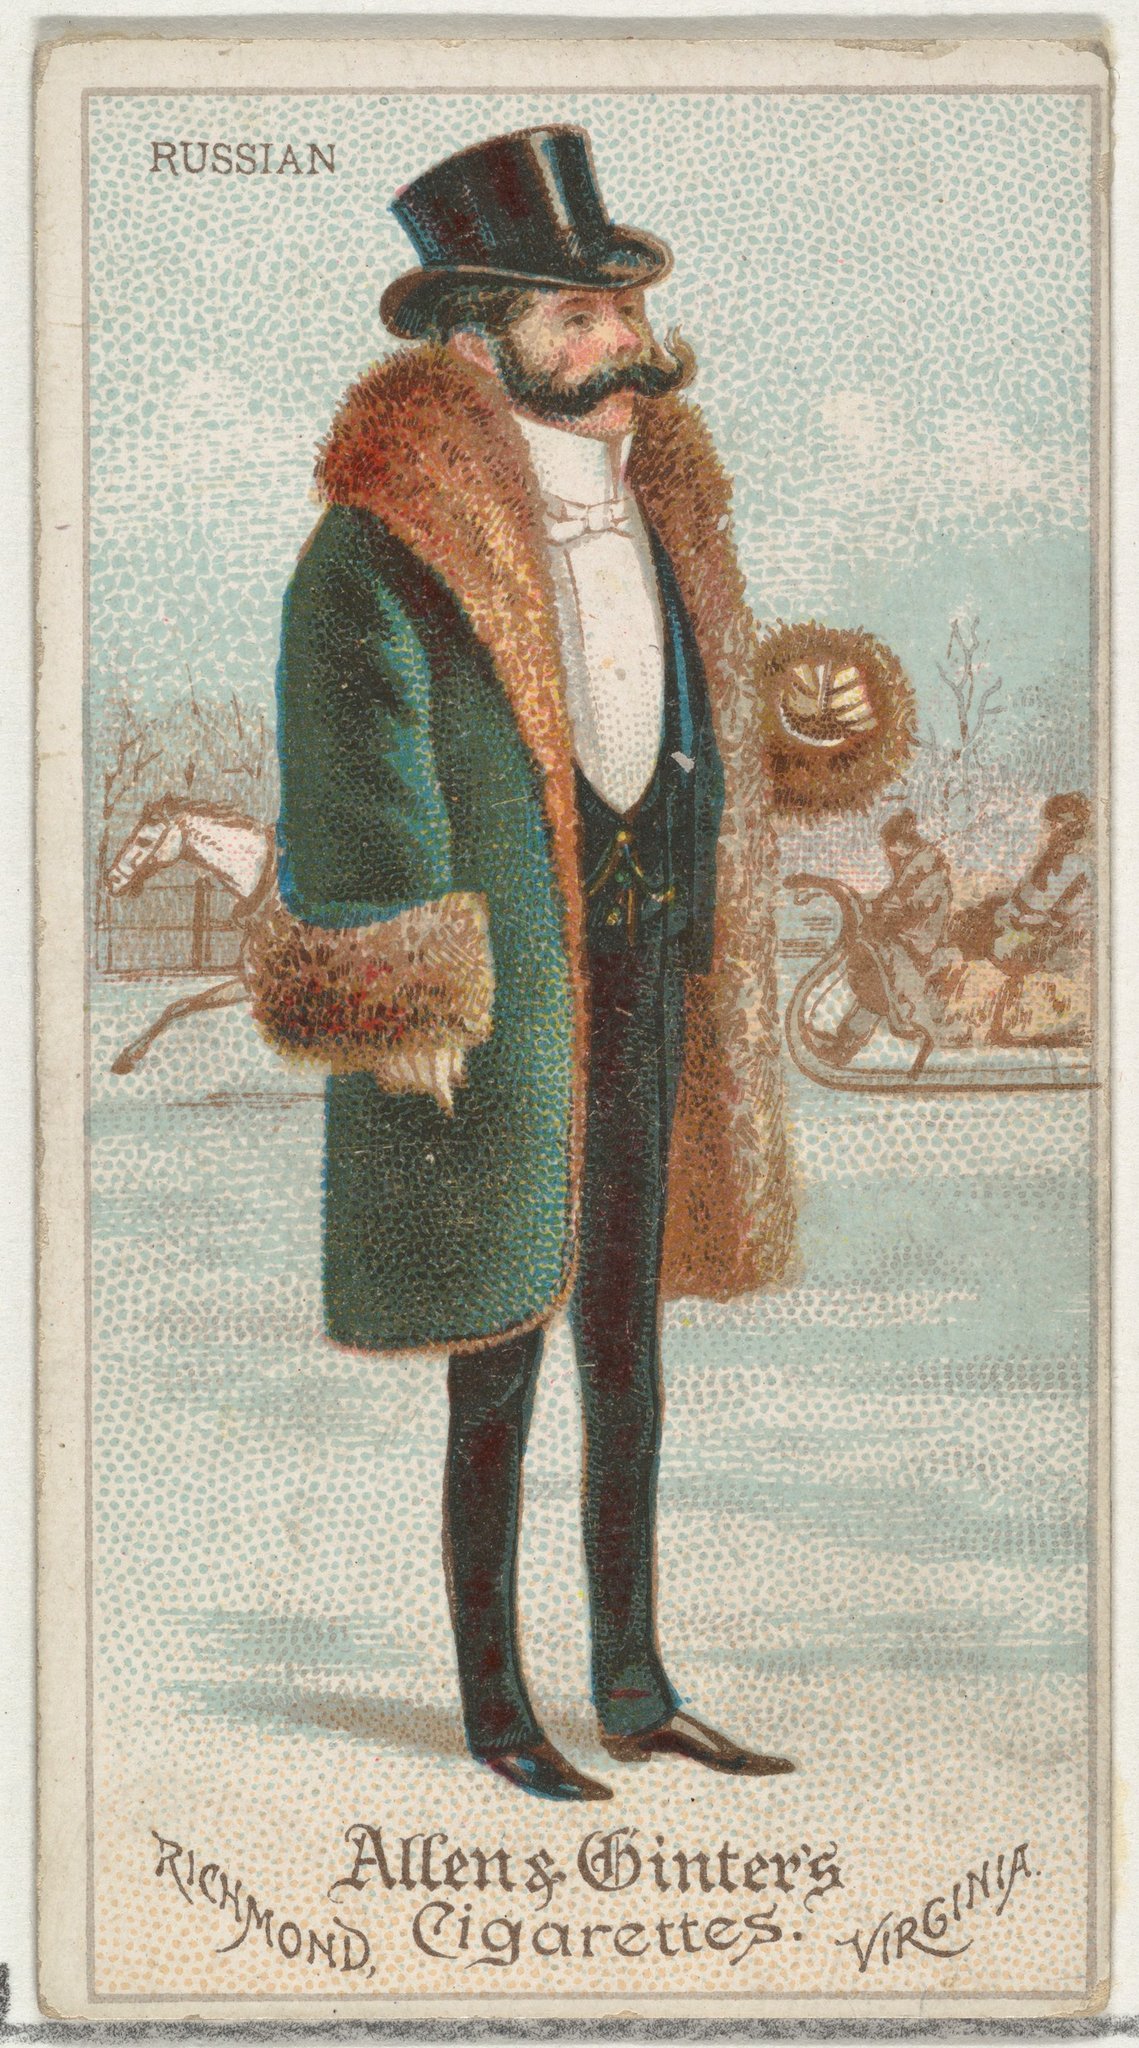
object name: print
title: Russian, from World's Dudes series (N31) for Allen & Ginter Cigarettes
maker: allen & ginter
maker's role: publisher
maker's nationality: american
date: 1888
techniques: color lithograph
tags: men